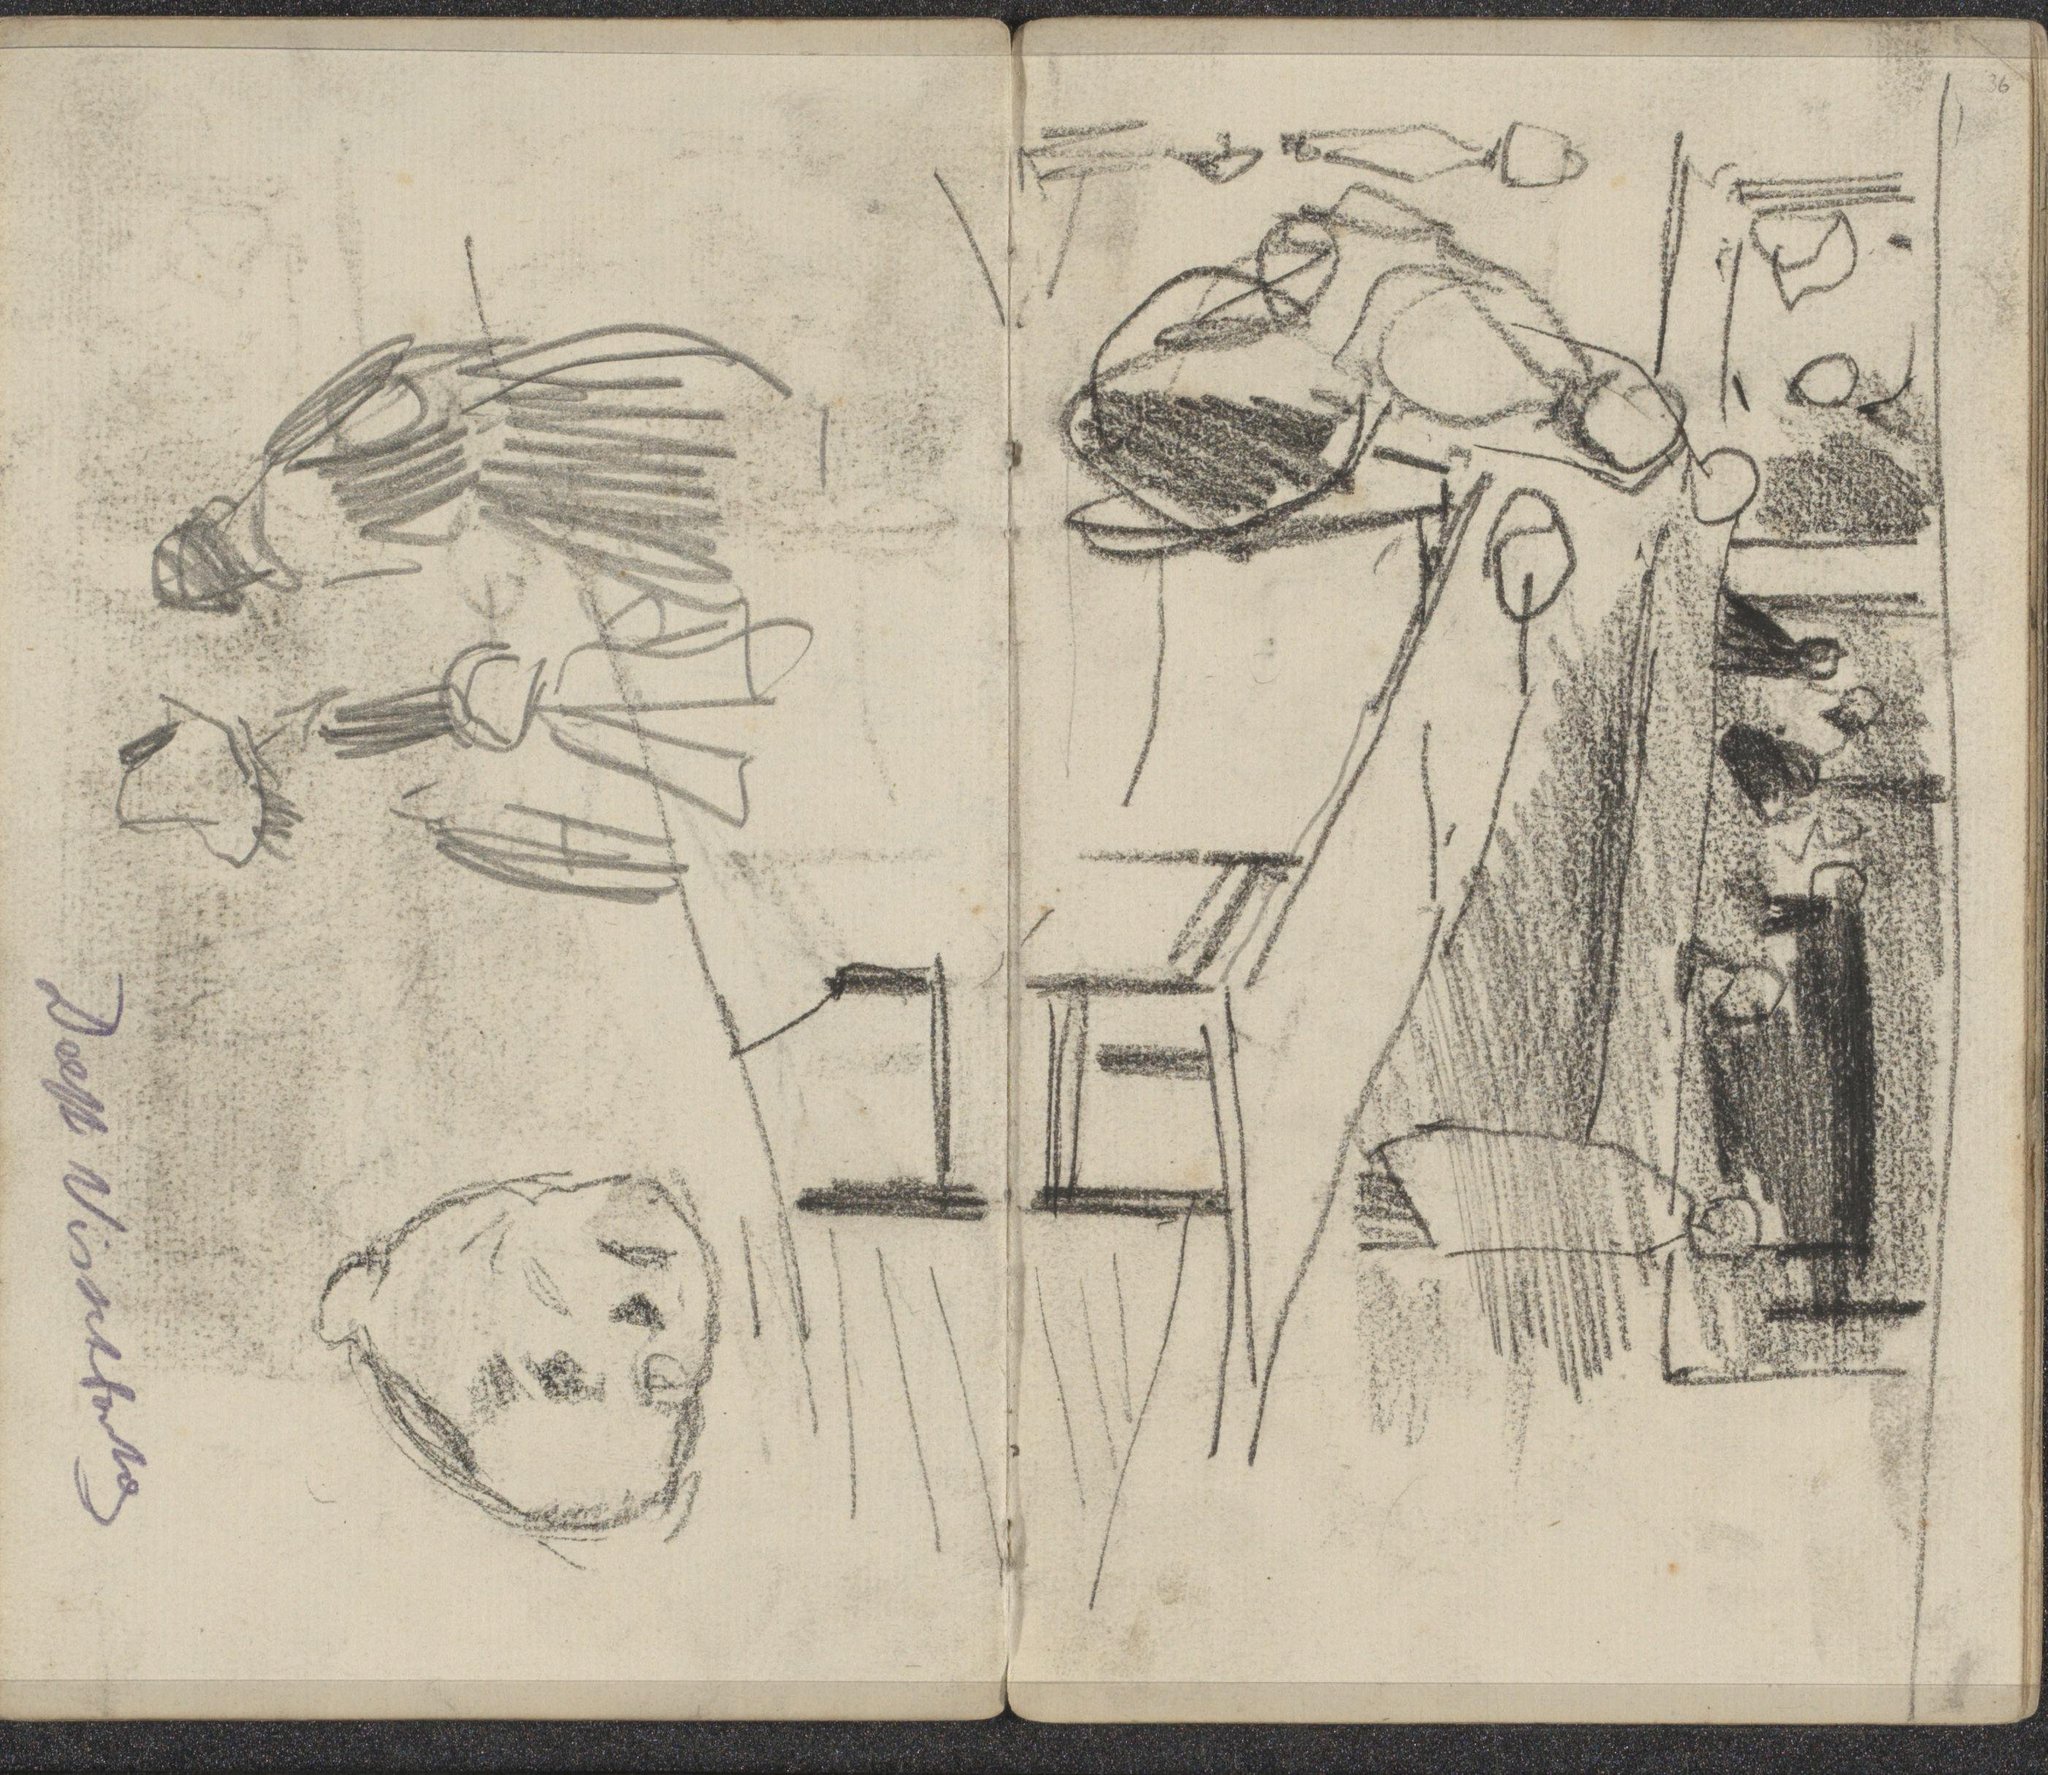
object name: sketchbook leaf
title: Figuren in de Visbank te Delft en figuurstudies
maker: george hendrik breitner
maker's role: draughtsman, painter, print maker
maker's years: 1857-1923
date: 1887-1889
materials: chalk, paper, pencil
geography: delft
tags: face, adult woman, adult man, market-hall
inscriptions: annotation: ‘Delft Vischbank’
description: Pagina 35 en pagina 36 uit een schetsboek met 27 bladen.